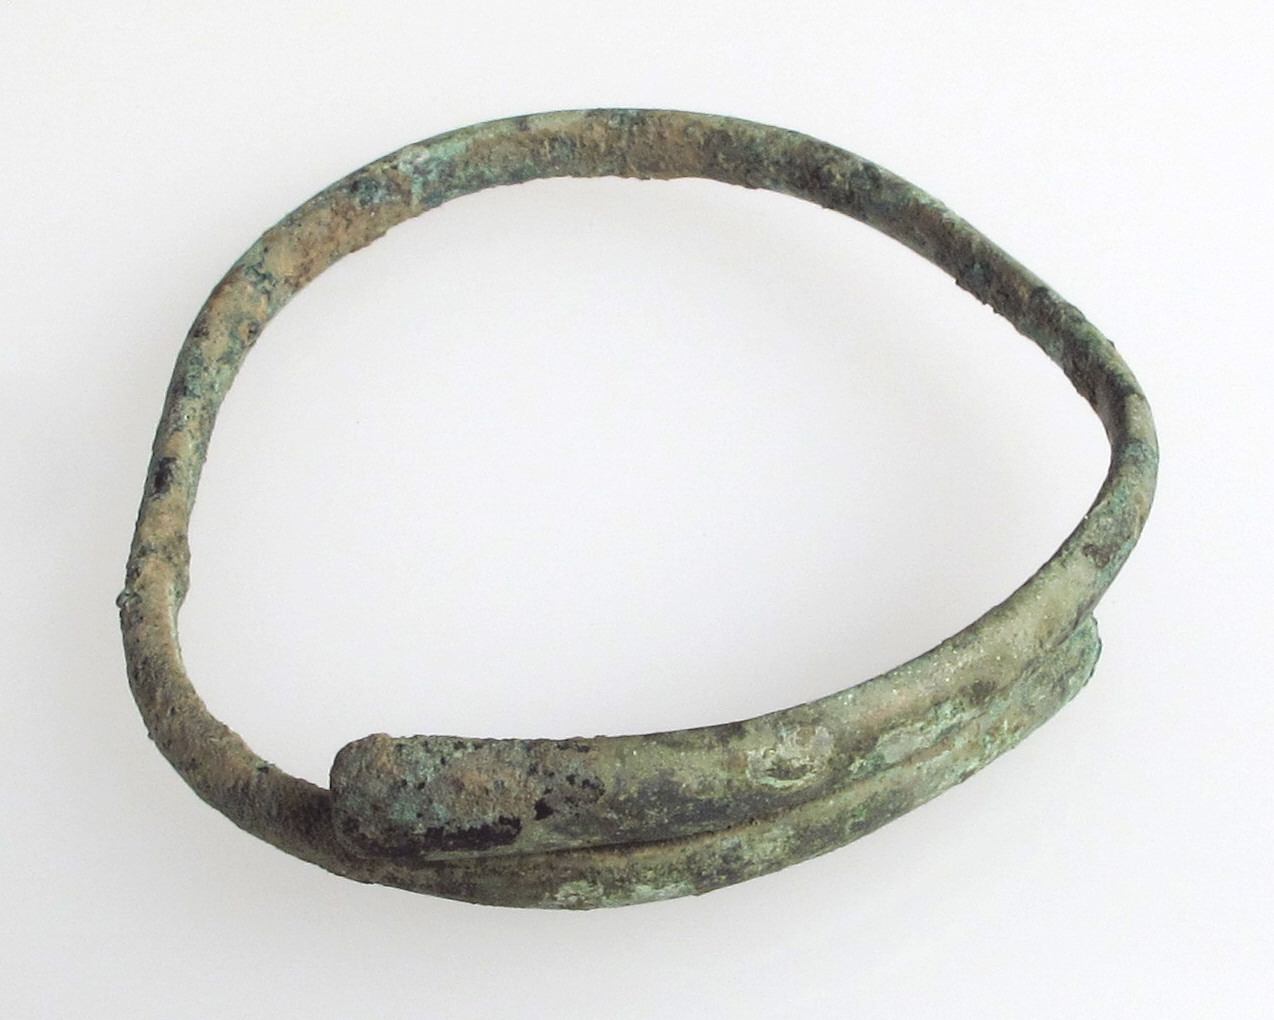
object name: armlet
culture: celtic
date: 400-100 BCE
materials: copper alloy